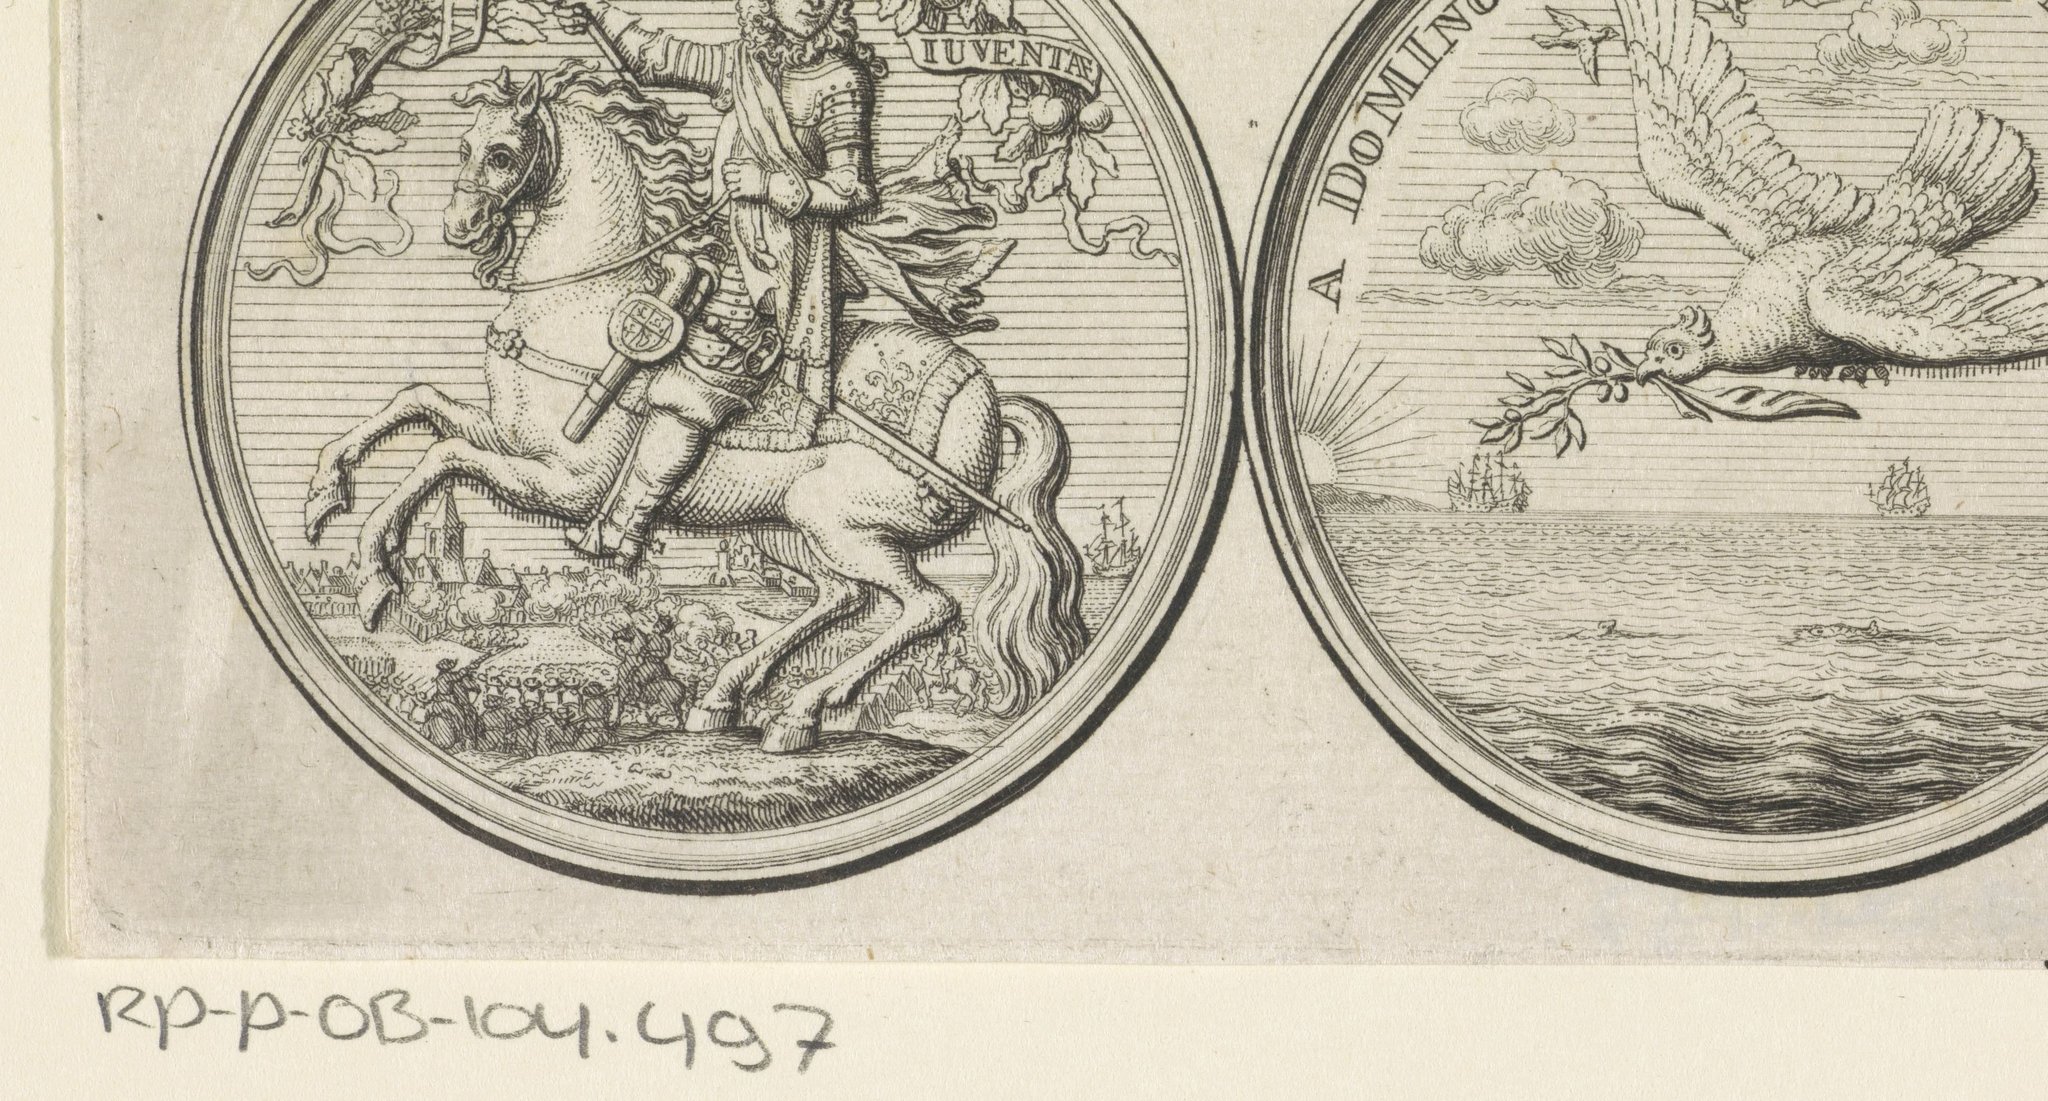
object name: print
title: Penning met ruiterportret van Willem III, prins van Oranje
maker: Anonymous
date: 1700-1799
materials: paper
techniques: engraving, etching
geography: low countries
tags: the hague, william iii (prince of orange and king of england, scotland, and ireland)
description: De hier vermelde titel verwijst naar de hoogst verkregen titel van de geportretteerde, niet per se naar de titel die de geportretteerde op deze voorstelling draagt.